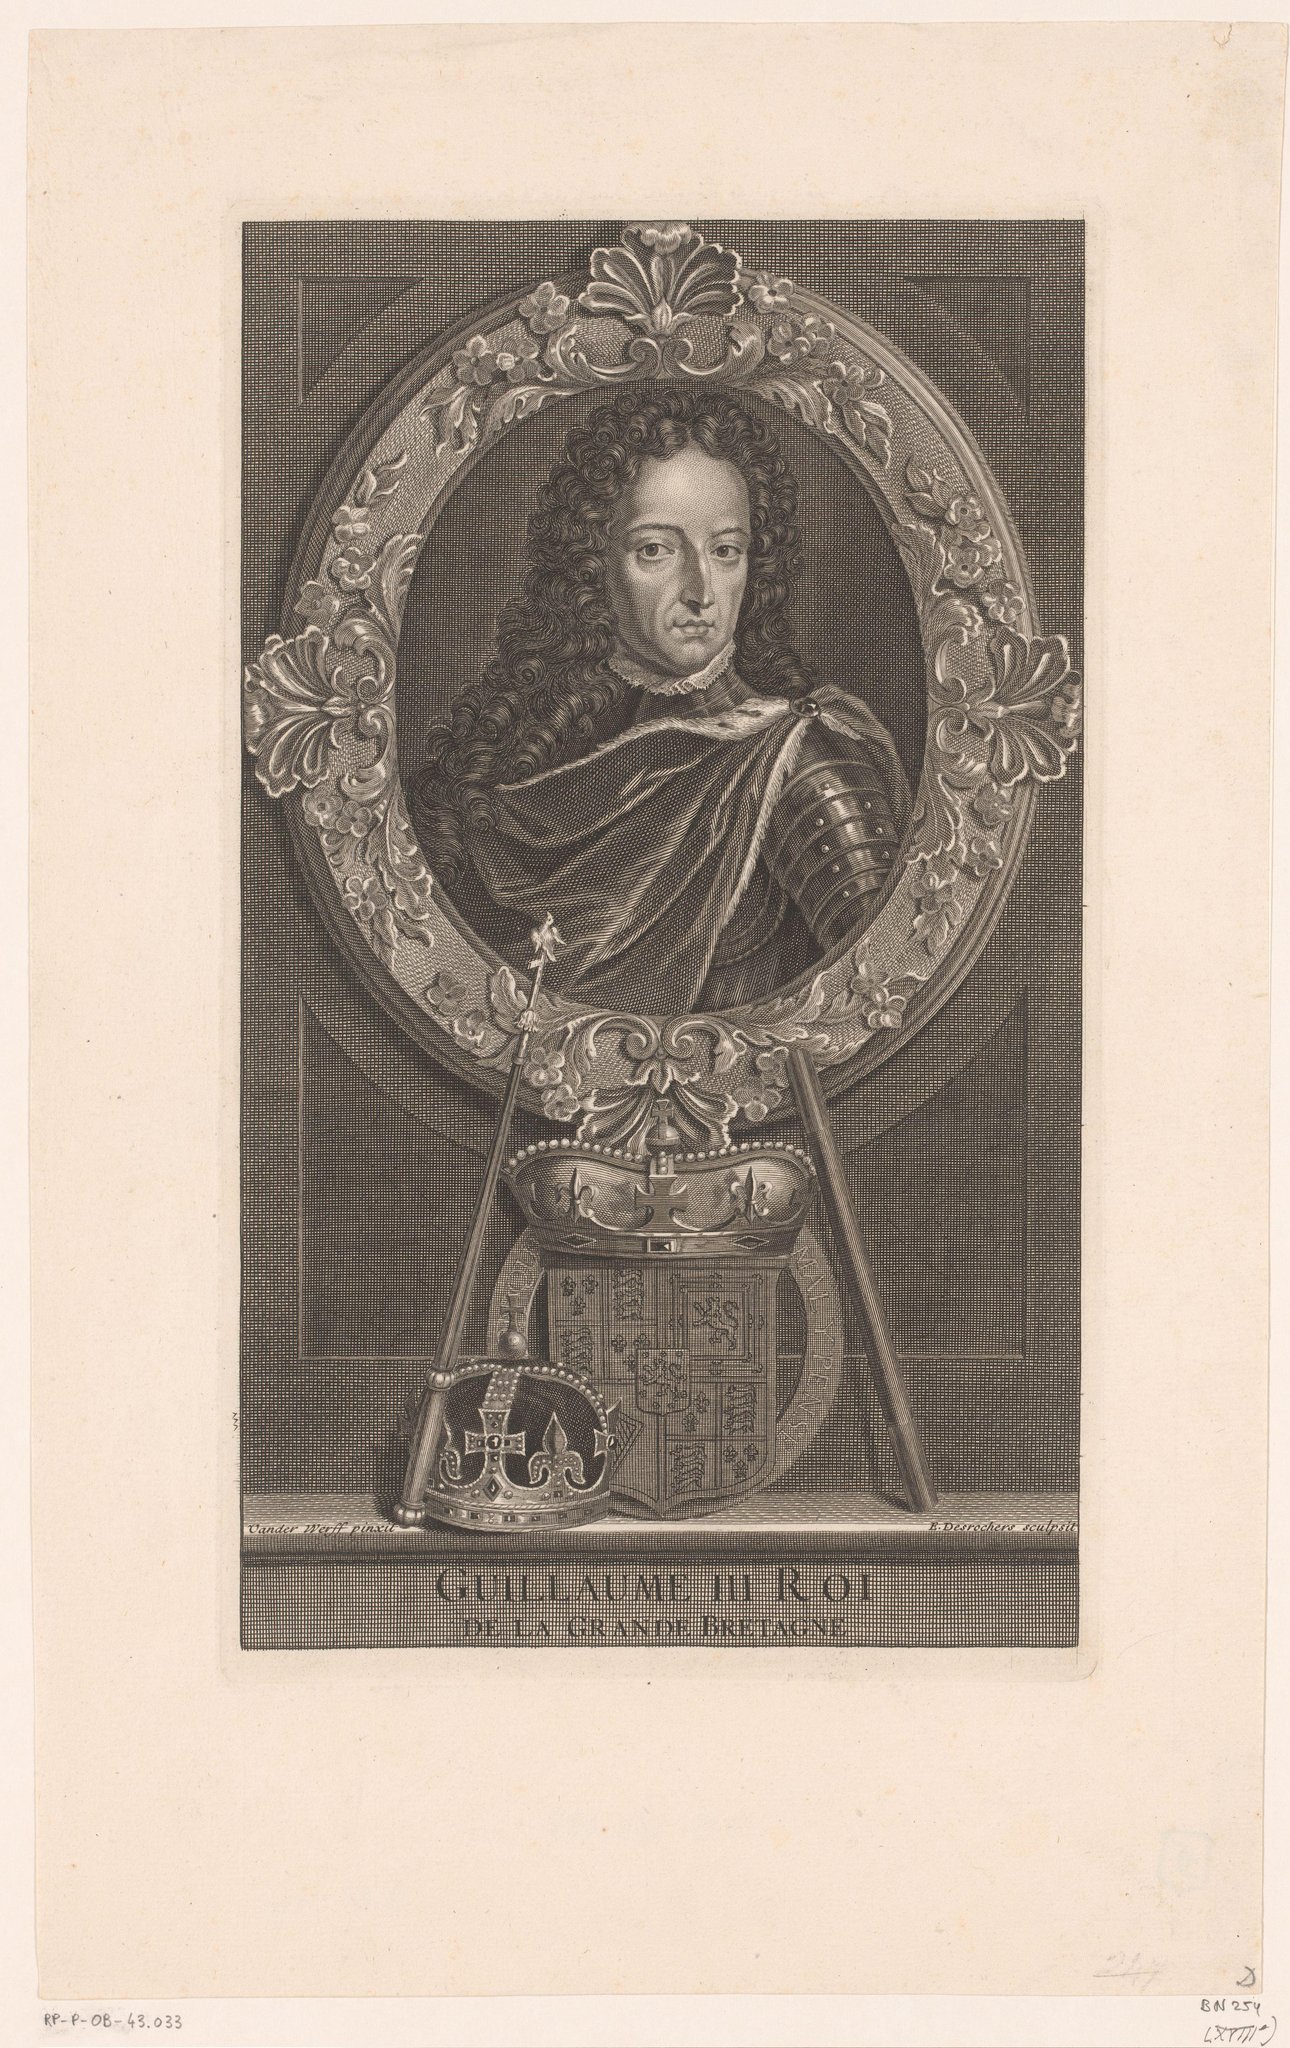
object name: print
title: Portret van koning Willem III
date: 1678-1741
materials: paper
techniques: engraving, etching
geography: paris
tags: the hague, william iii (prince of orange and king of england, scotland, and ireland), historical persons, king, armorial bearing, heraldry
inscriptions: collector's mark: Lugt 963, collector's mark: Lugt 2228